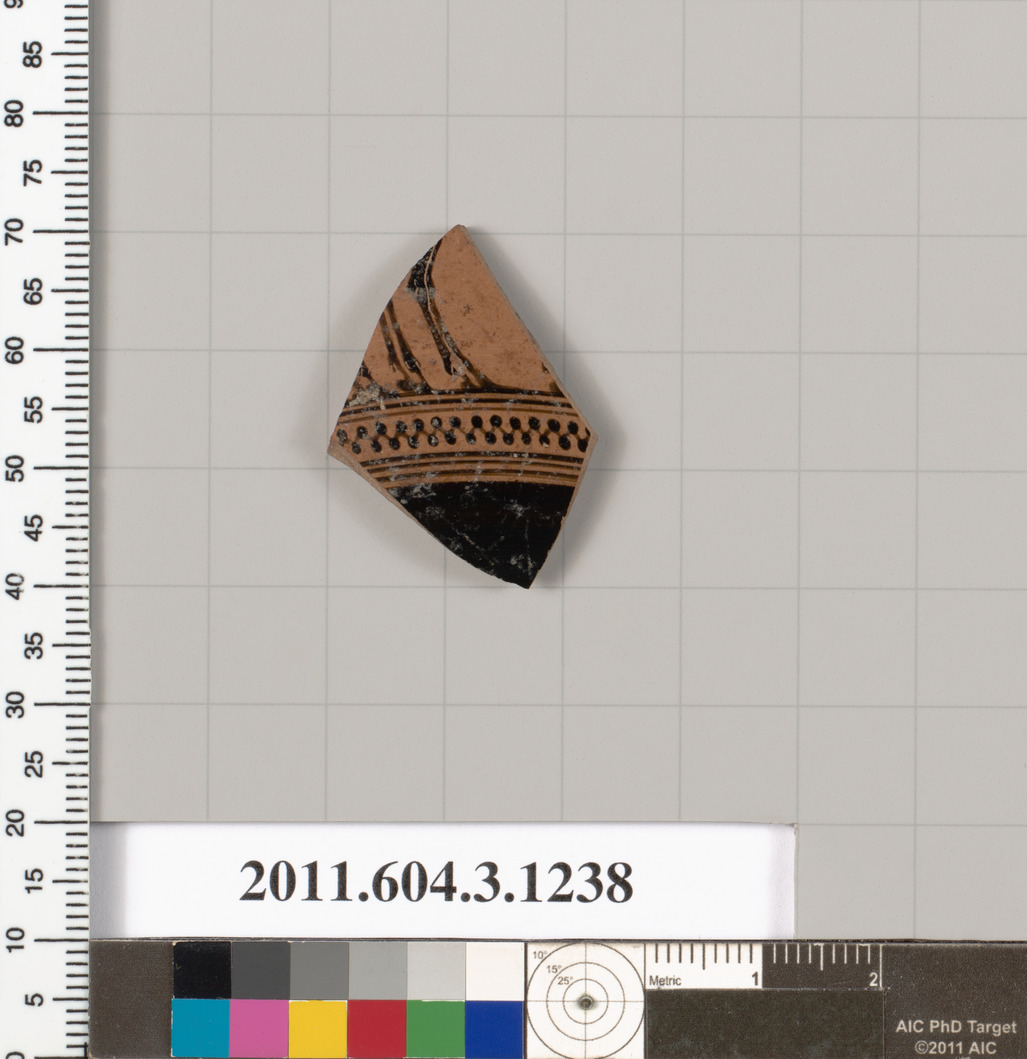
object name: kyathos fragment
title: Terracotta fragment of a kyathos (cup-shaped ladle)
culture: greek, attic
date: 534-501 BCE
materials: terracotta